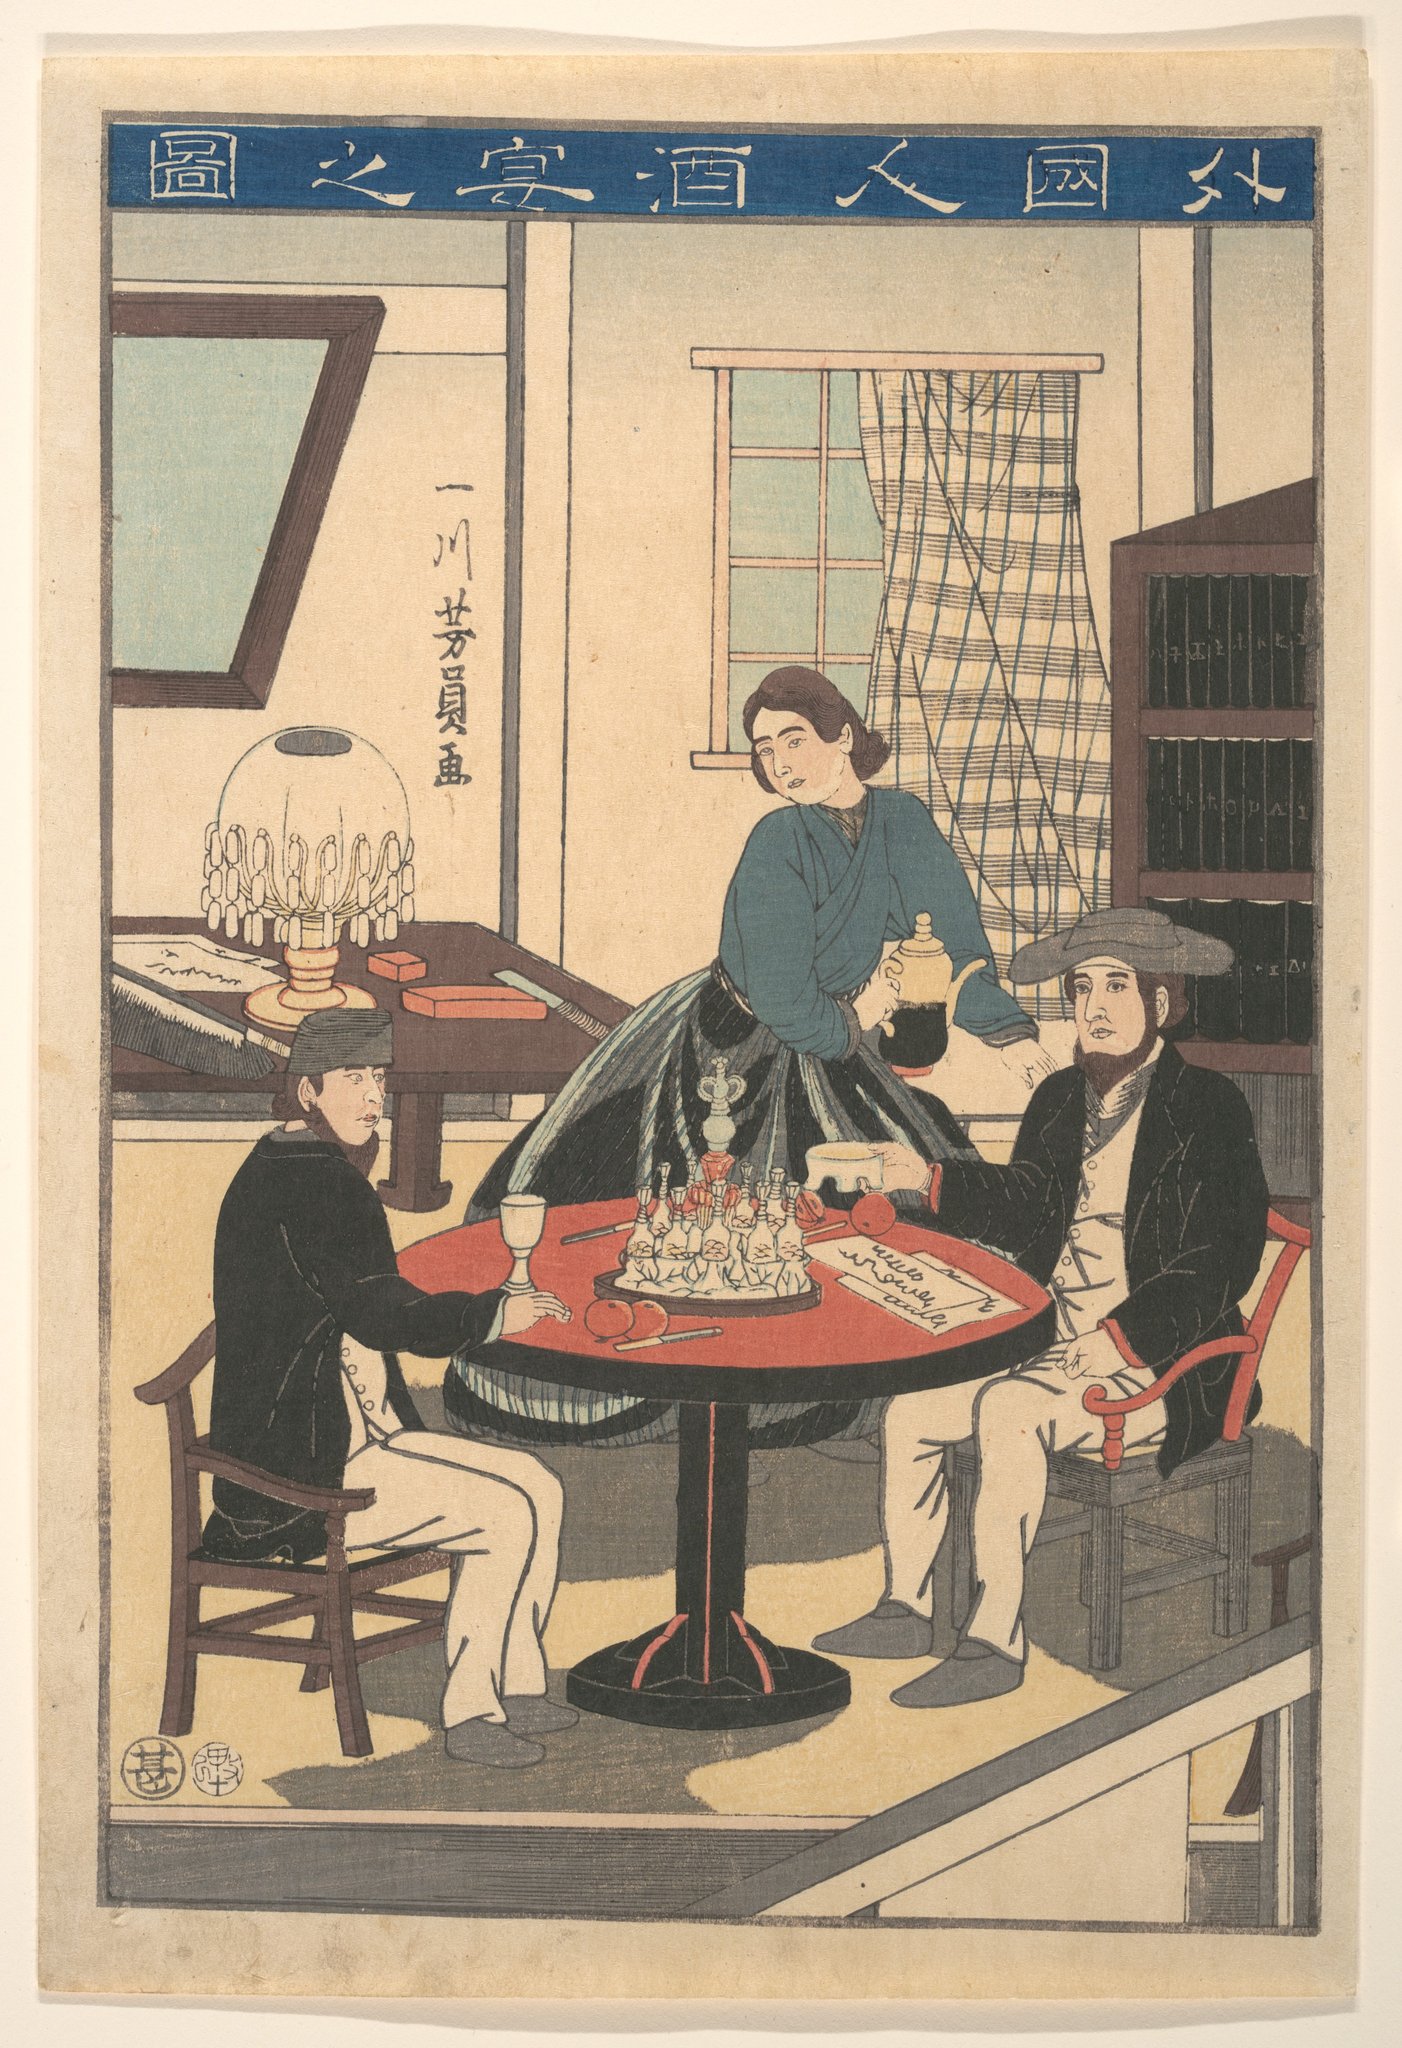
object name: print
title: A Foreigner's Wine Party (Gaikokujin shuen no zu), from an untitled series of foreigners at home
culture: japanese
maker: utagawa yoshikazu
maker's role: artist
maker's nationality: japanese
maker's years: 1845-1870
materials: ink, paper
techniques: woodblock print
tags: men,women,party,drinking